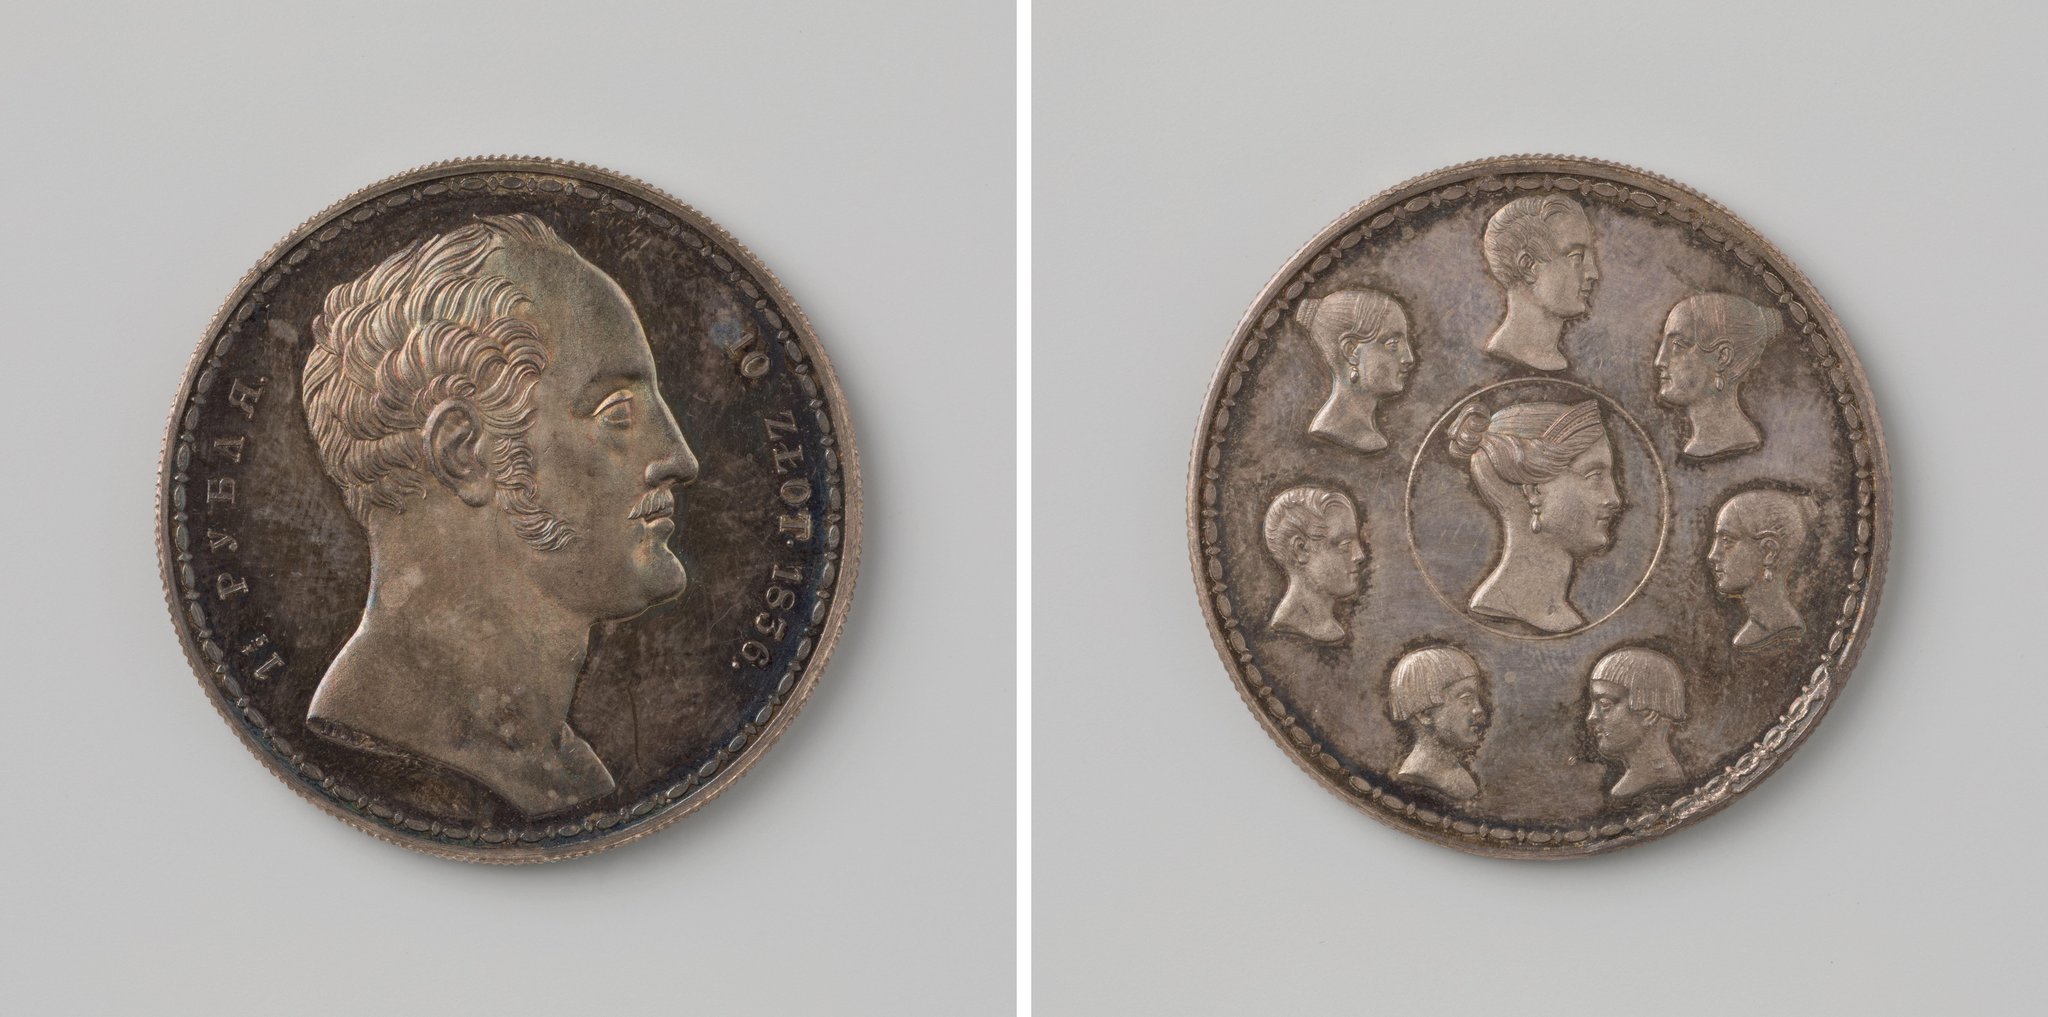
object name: coin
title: 1½ roebel of 10 zlotych uit Polen van tsaar Nikolai I, 1836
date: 1836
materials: silver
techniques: striking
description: Zilveren munt. Voorzijde: hoofd van de vorst naar rechts. Waarde-aanduidingen en jaartal als omschrift. Keerzijde: in het midden in een cirkel het hoofd vasn de keizerin naar rechts, waaromheen de hoofden van haar vier zoons en drie dochters. Kartelrand.